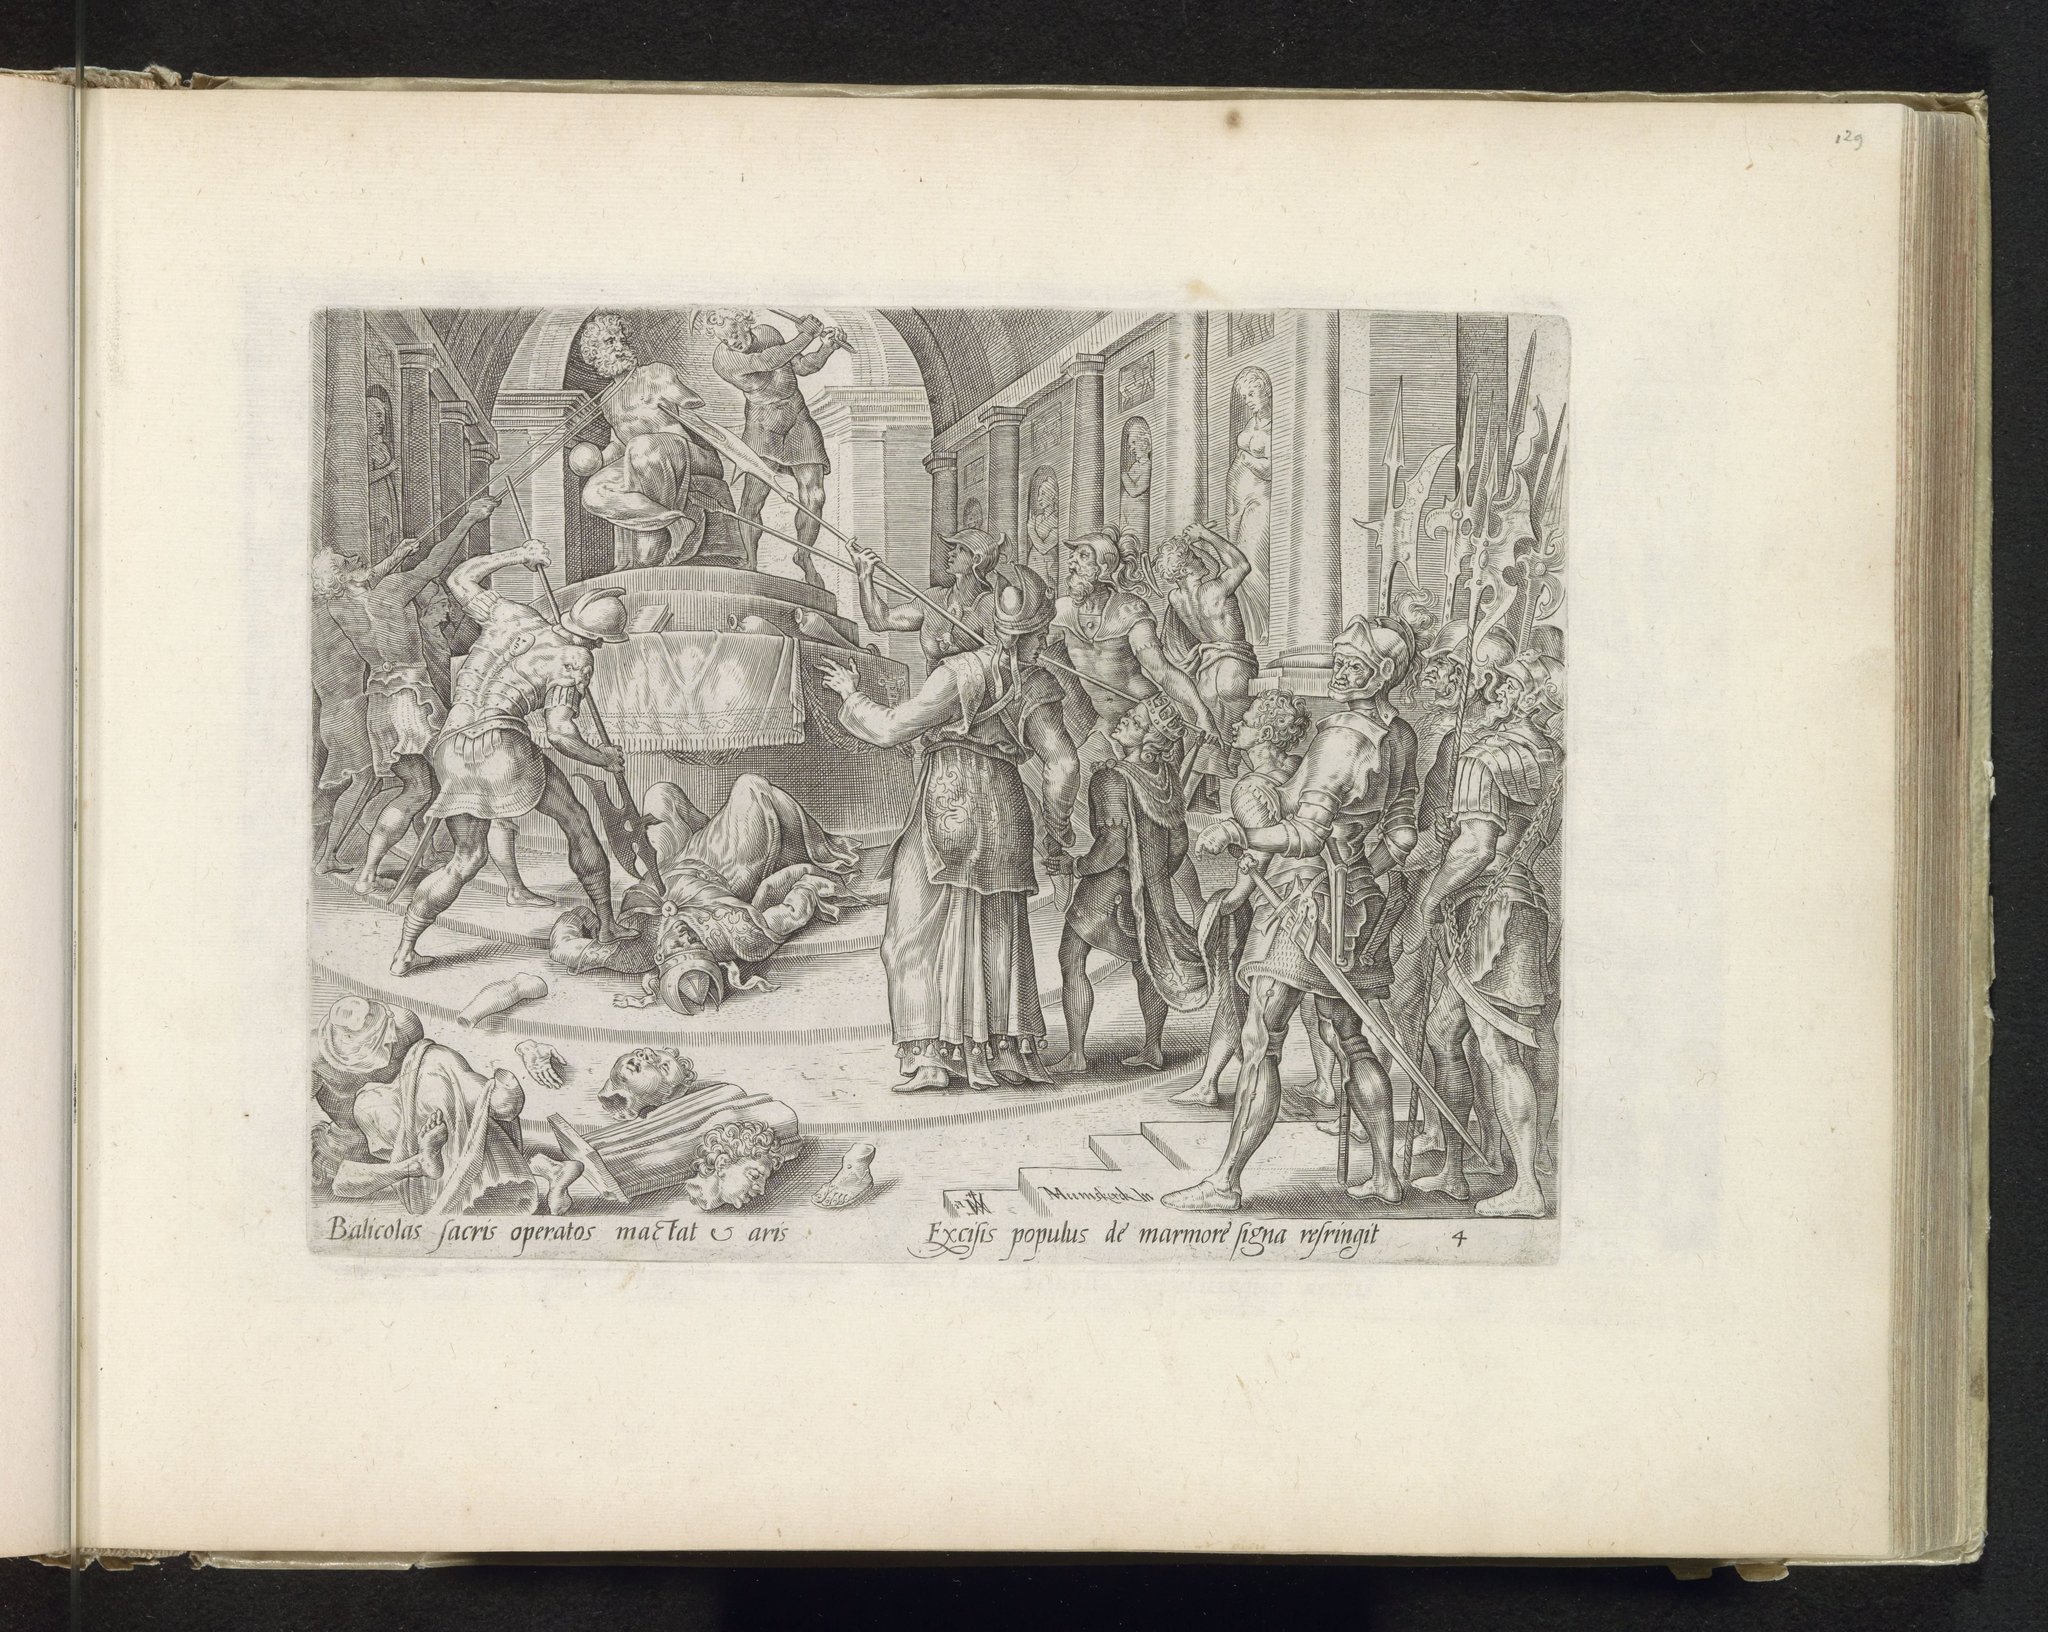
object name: album leaf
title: Geschiedenis van Joas en koningin Atalja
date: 1585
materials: paper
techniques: engraving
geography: amsterdam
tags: the people destroy the temple, altars and images of baal, and slay baal's priests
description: In de tempel van Baäl halen mensen de afgodsbeelden omver. Voor het altaar wordt de Baälspriester gedood met een hellebaard. De hogepriester Jojada kijkt met de zevenjarige koning Joas aan de hand toe. Onderaan in de marge een vers in het Latijn over de voorstelling. Deze prent maakt deel uit van een album.